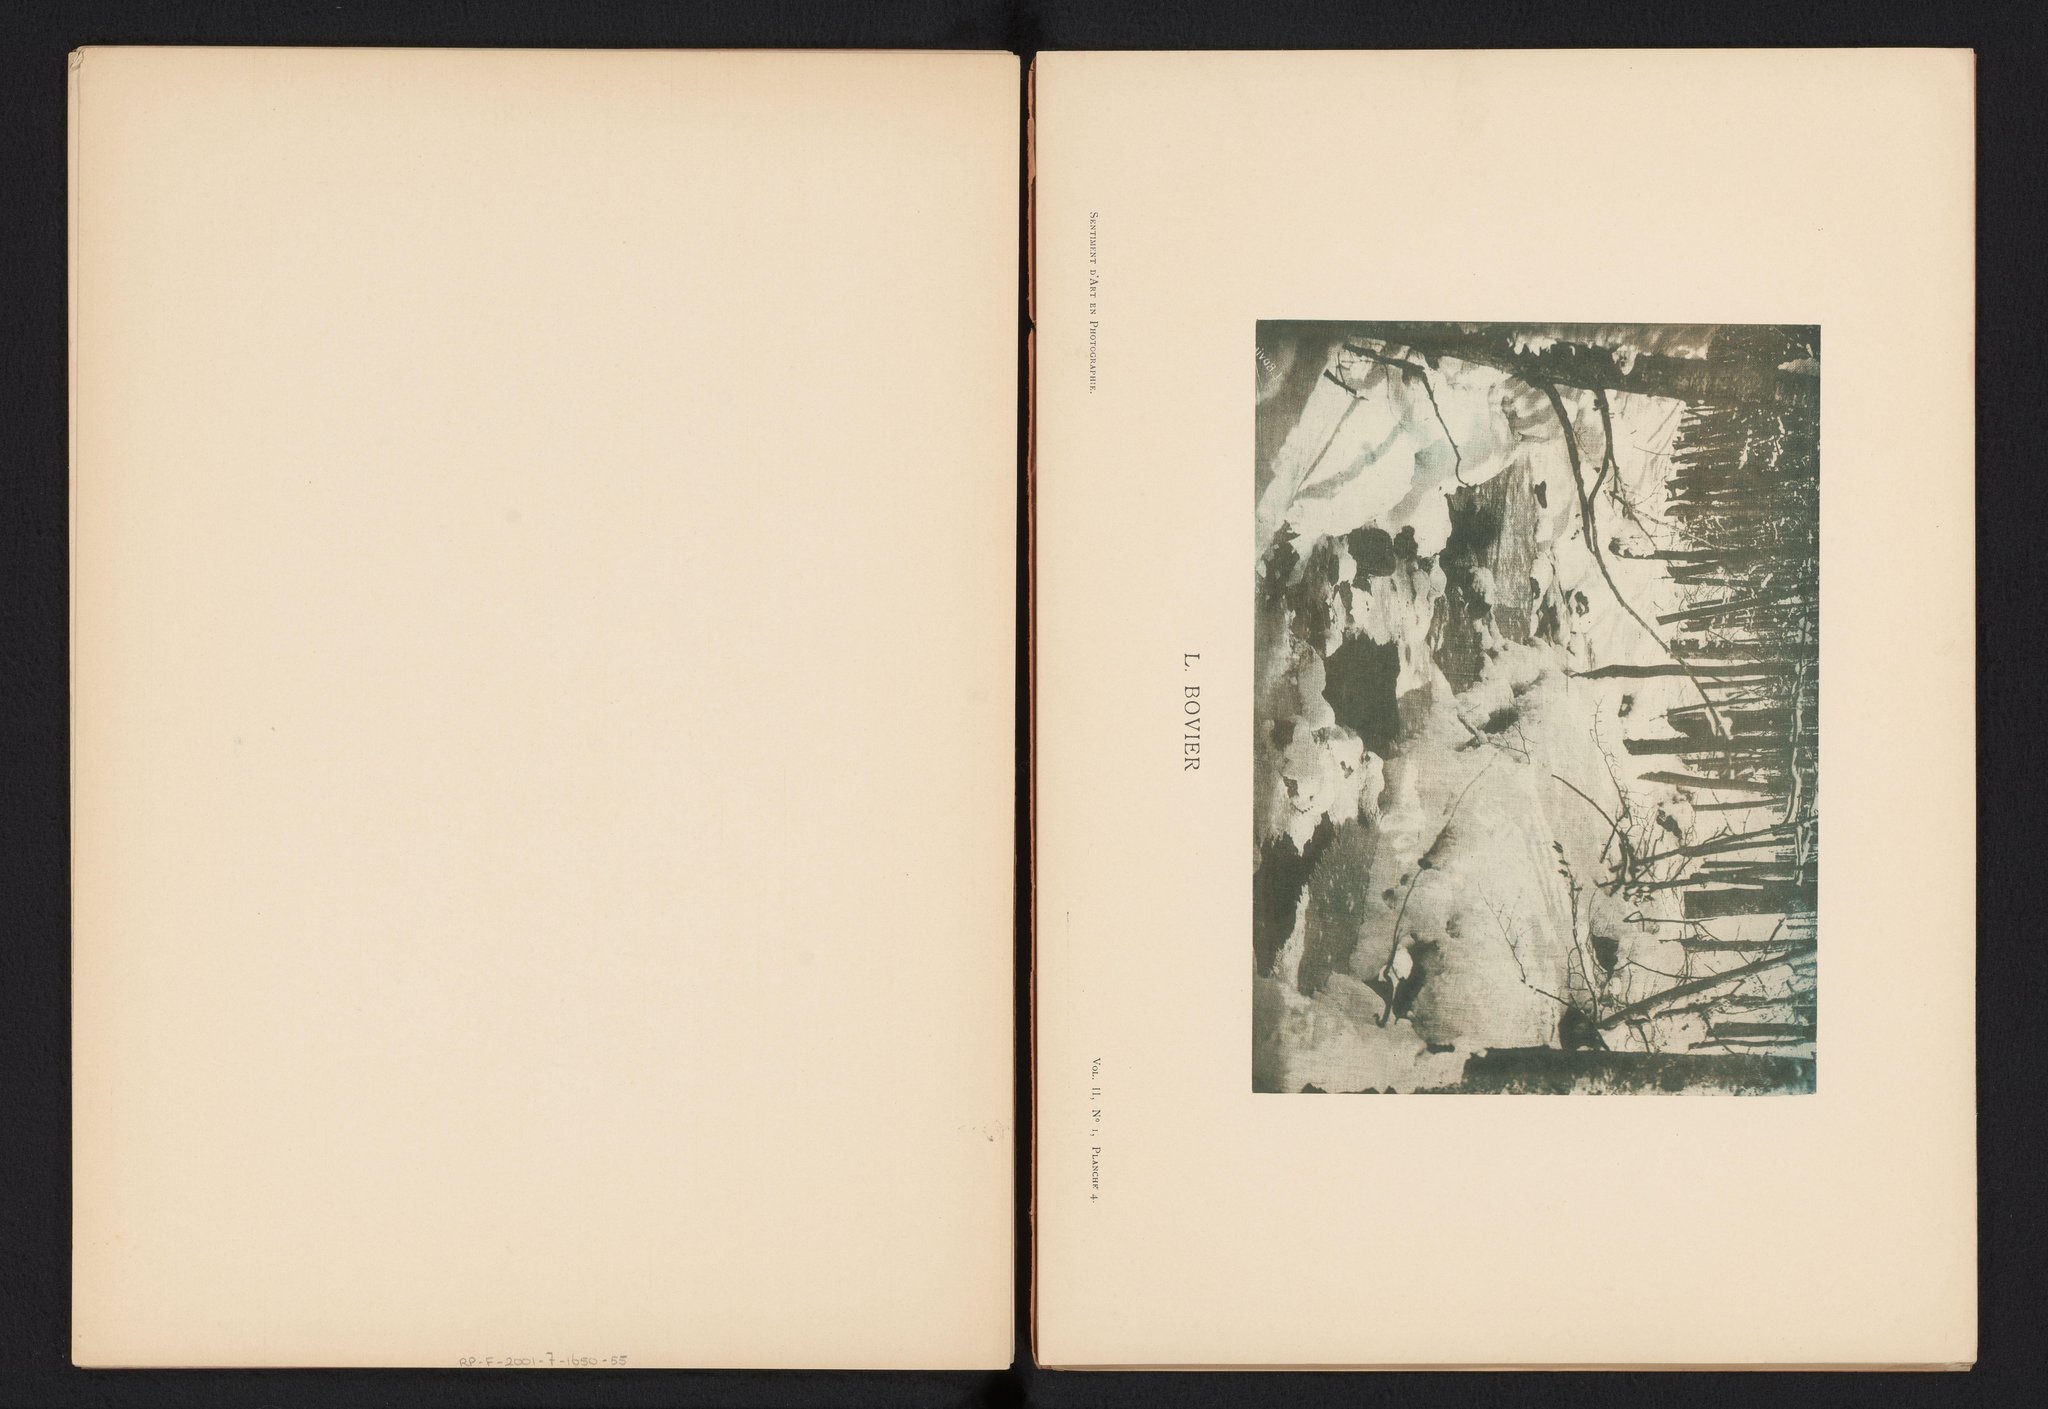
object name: photomechanical print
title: Winterlandschap met een beek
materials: paper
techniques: photograph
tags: winter landscape; landscape symbolizing winter (the four seasons of the year), brook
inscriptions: number: ‘Vol. II, No 1, Planche 4.’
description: Deze prent maakt deel uit van 8 omslagen met 22 tekstbladen en 89 prenten op losse bladen in en tussen de omslagen.